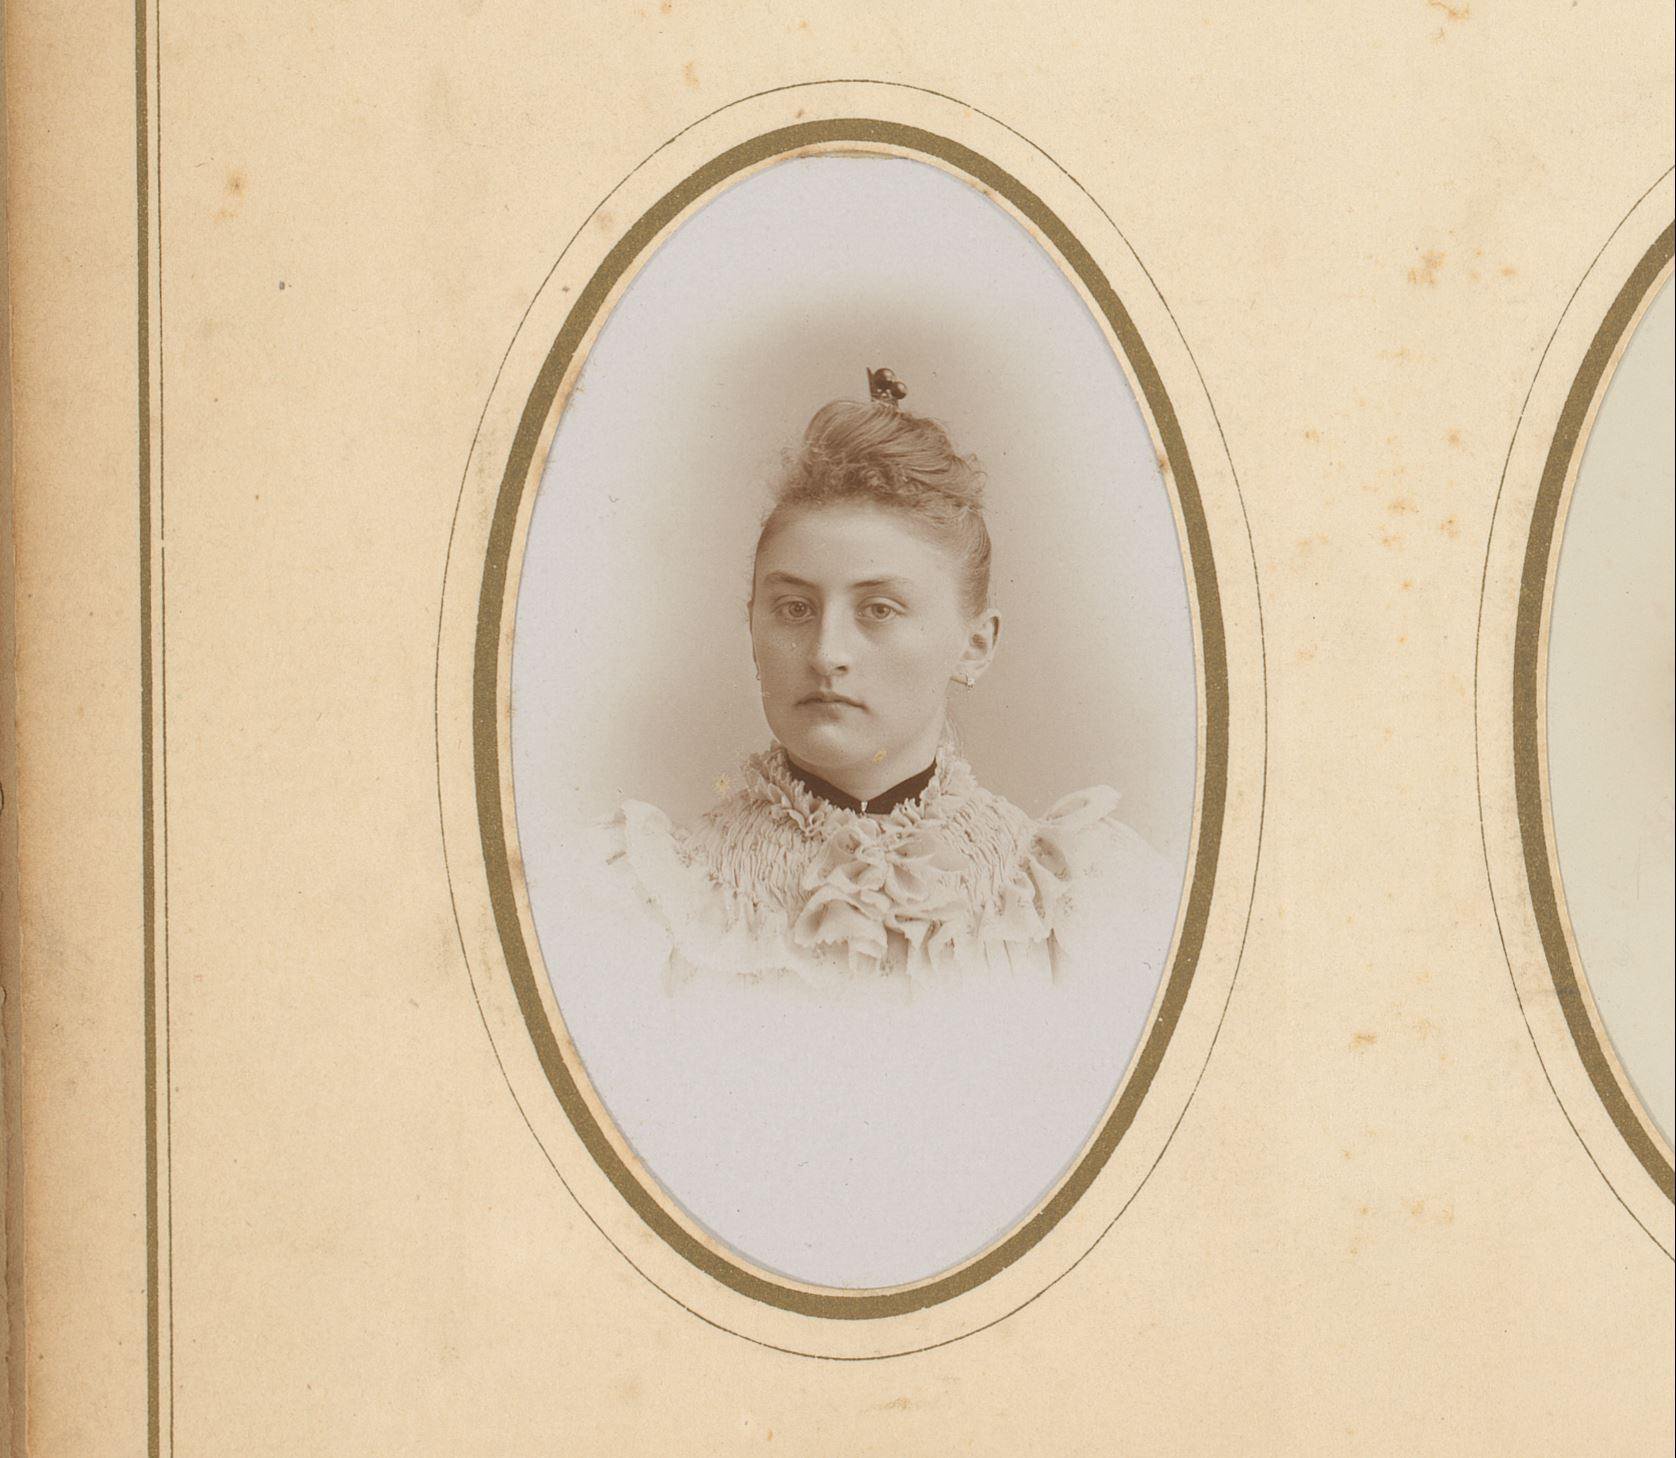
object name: photograph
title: Portret van een jonge vrouw met halsketting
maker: benjamin sanders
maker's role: fotograaf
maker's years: 1841-1889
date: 1880-1889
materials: cardboard, photographic support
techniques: collodion silver print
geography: groningen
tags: adolescent, young woman, maiden, historical persons - bb - woman, necklace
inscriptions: inscription: ‘Benj. Sanders/ GRONINGEN Heerestraat./ Vergrootingen naar kleine portretten worden prachtig/ afgewerkt en billyk in prys door my gelevert./ Deze portretten kunnen nabesteld worden.’